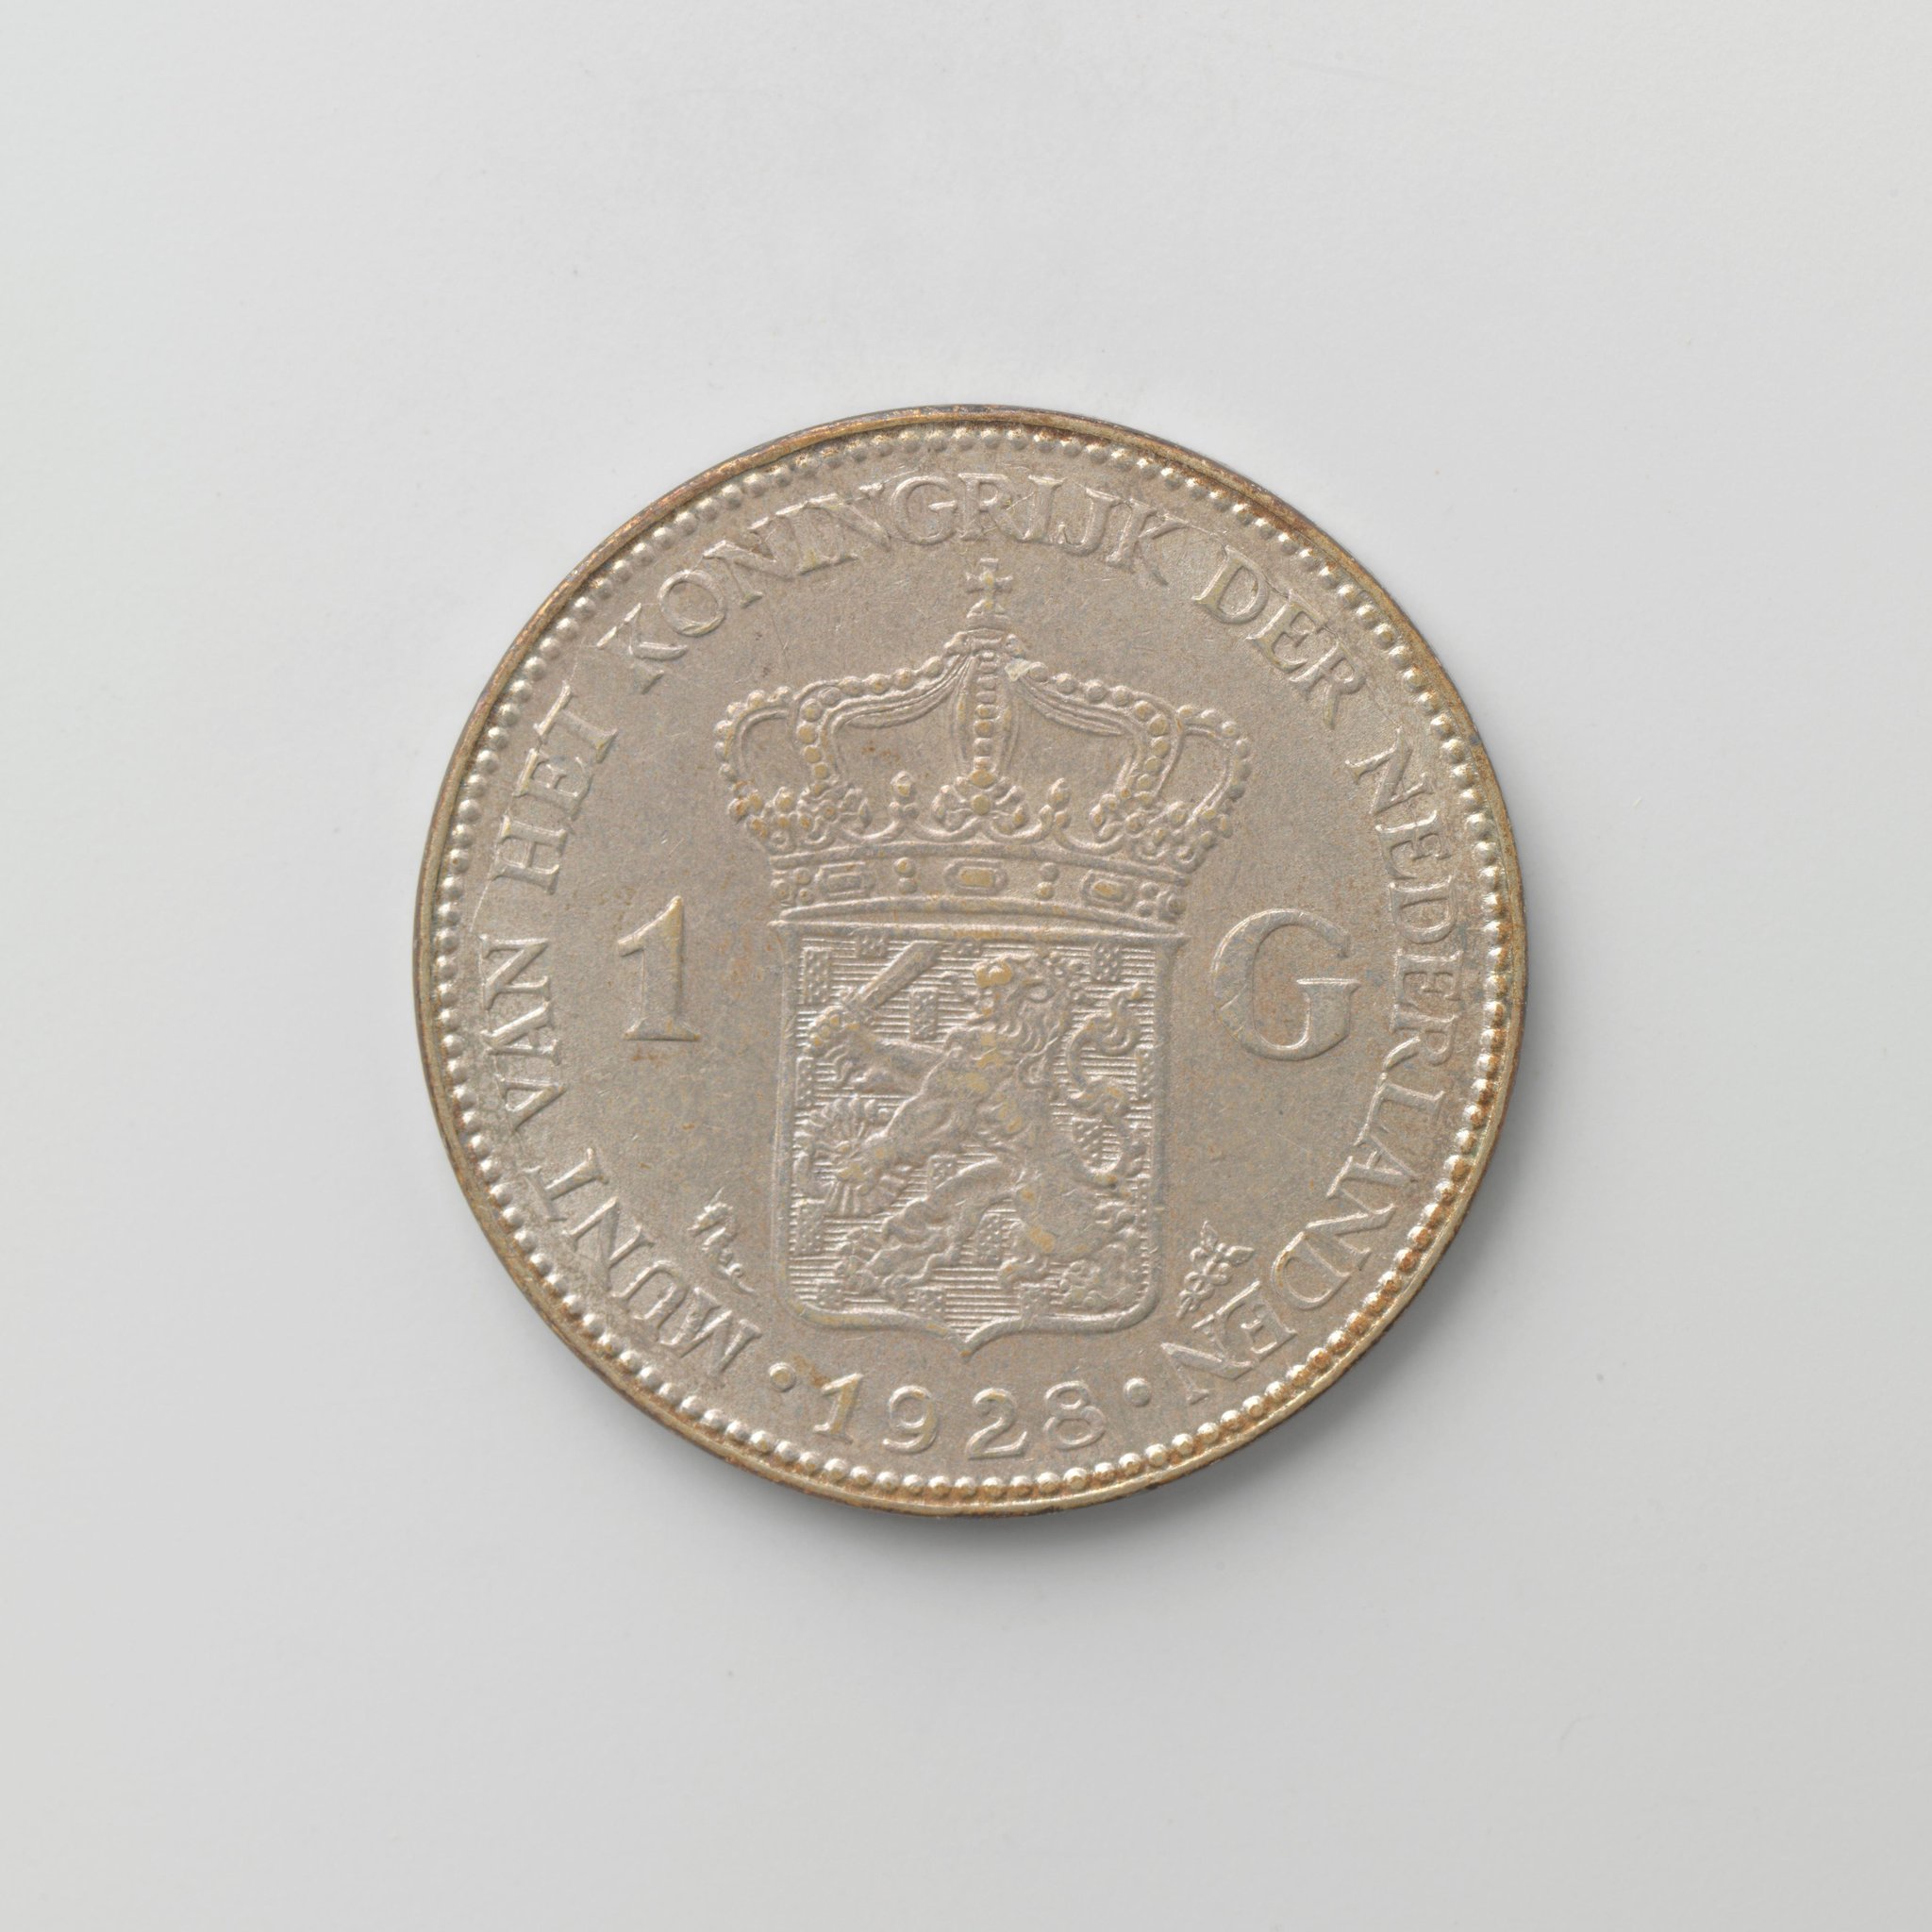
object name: coin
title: Nederland, gulden,1928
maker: wilhelmina of the netherlands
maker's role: print maker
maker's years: 1880-1962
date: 1928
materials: silver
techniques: striking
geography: utrecht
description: Zilveren munt. Voorzijde: hoofd naar links. Keerzijde: tussen waarde-aanduiding 1 G gekroond rijkswapenschild. Jaartal onderaan in omschrift. Randschrift.